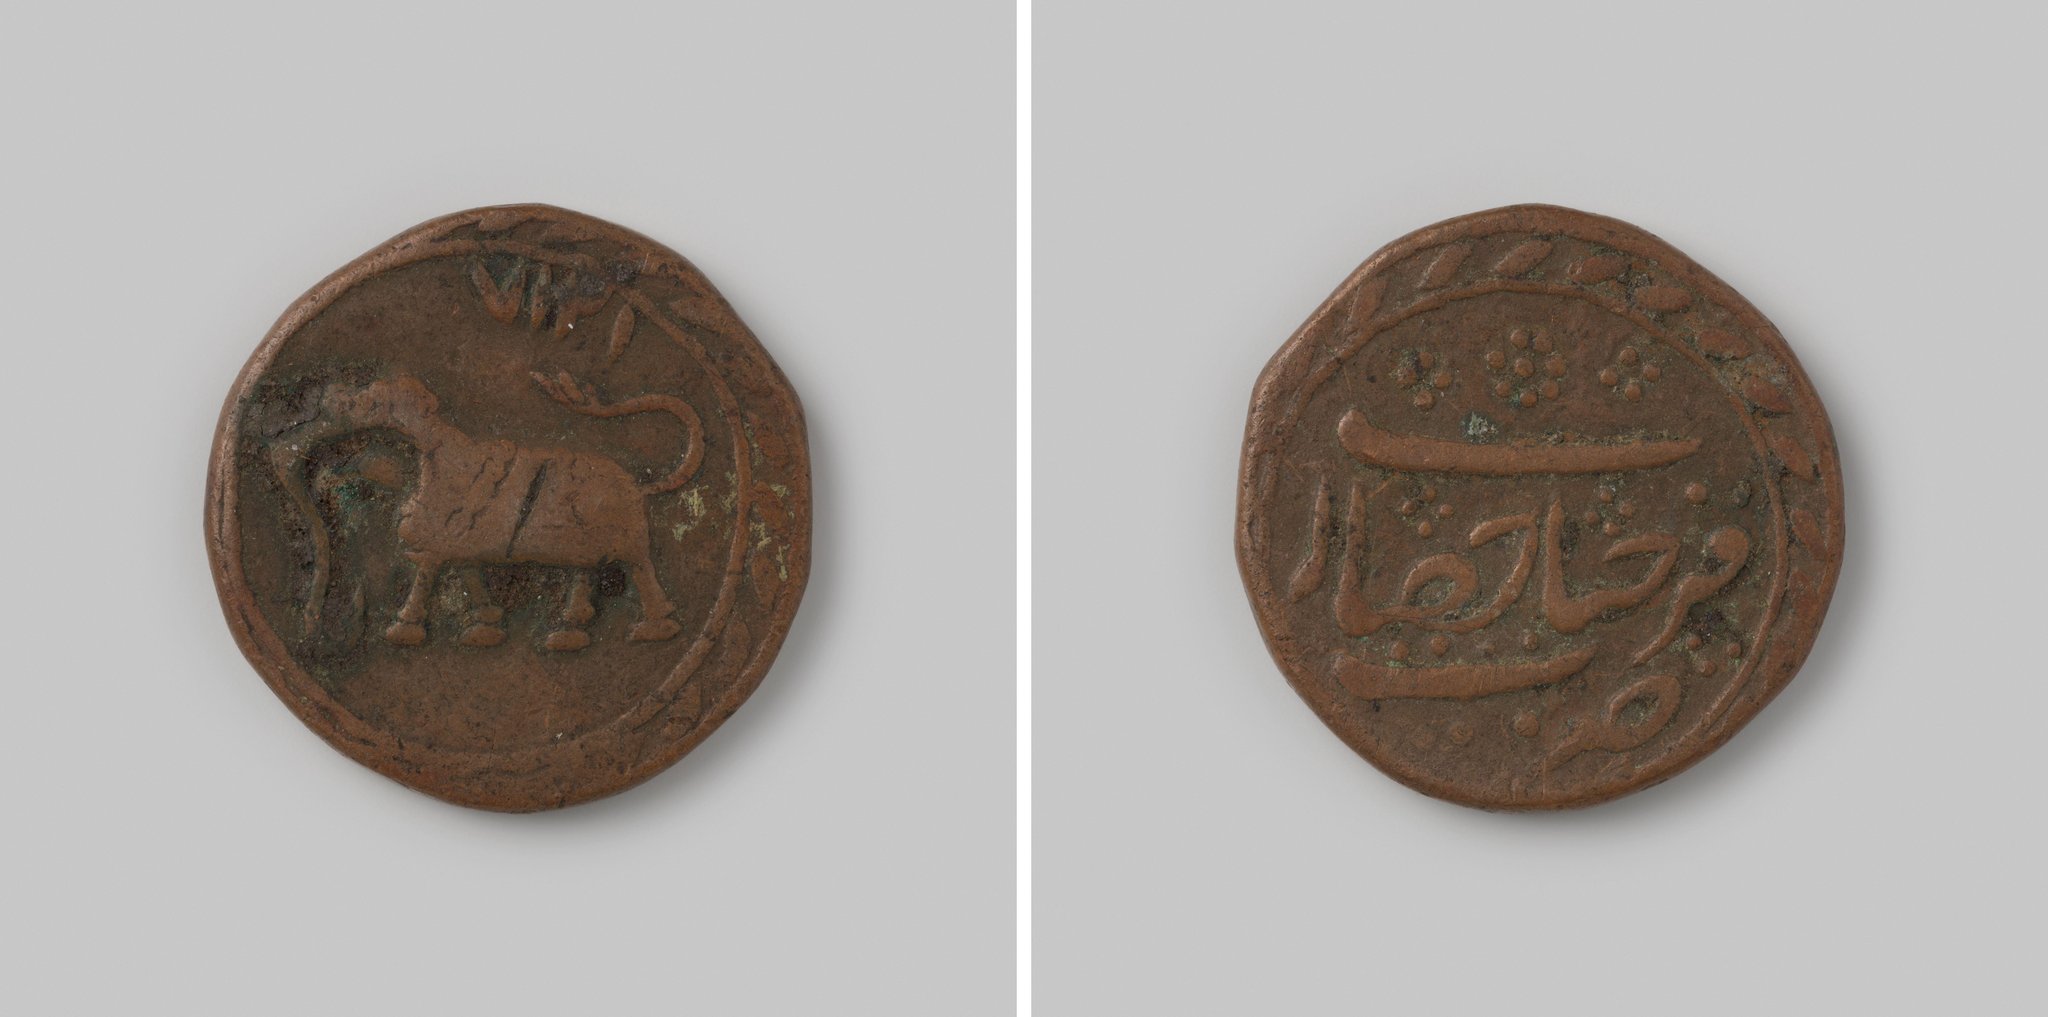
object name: coin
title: Paisa of zahra uit Mysore in India van Tipu Sultan, 1789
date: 1789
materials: copper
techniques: striking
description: Koperen munt. Voorzijde: binnen versierde rand olifant, lopend naar links. Daarboven jaartal: 1217 AM [=1789], geschreven van rechts naar links. Keerzijde: binen versierde rand in Arabische lettertekens in twee regels aanduiding muntplaats: Feiz-Hissar.